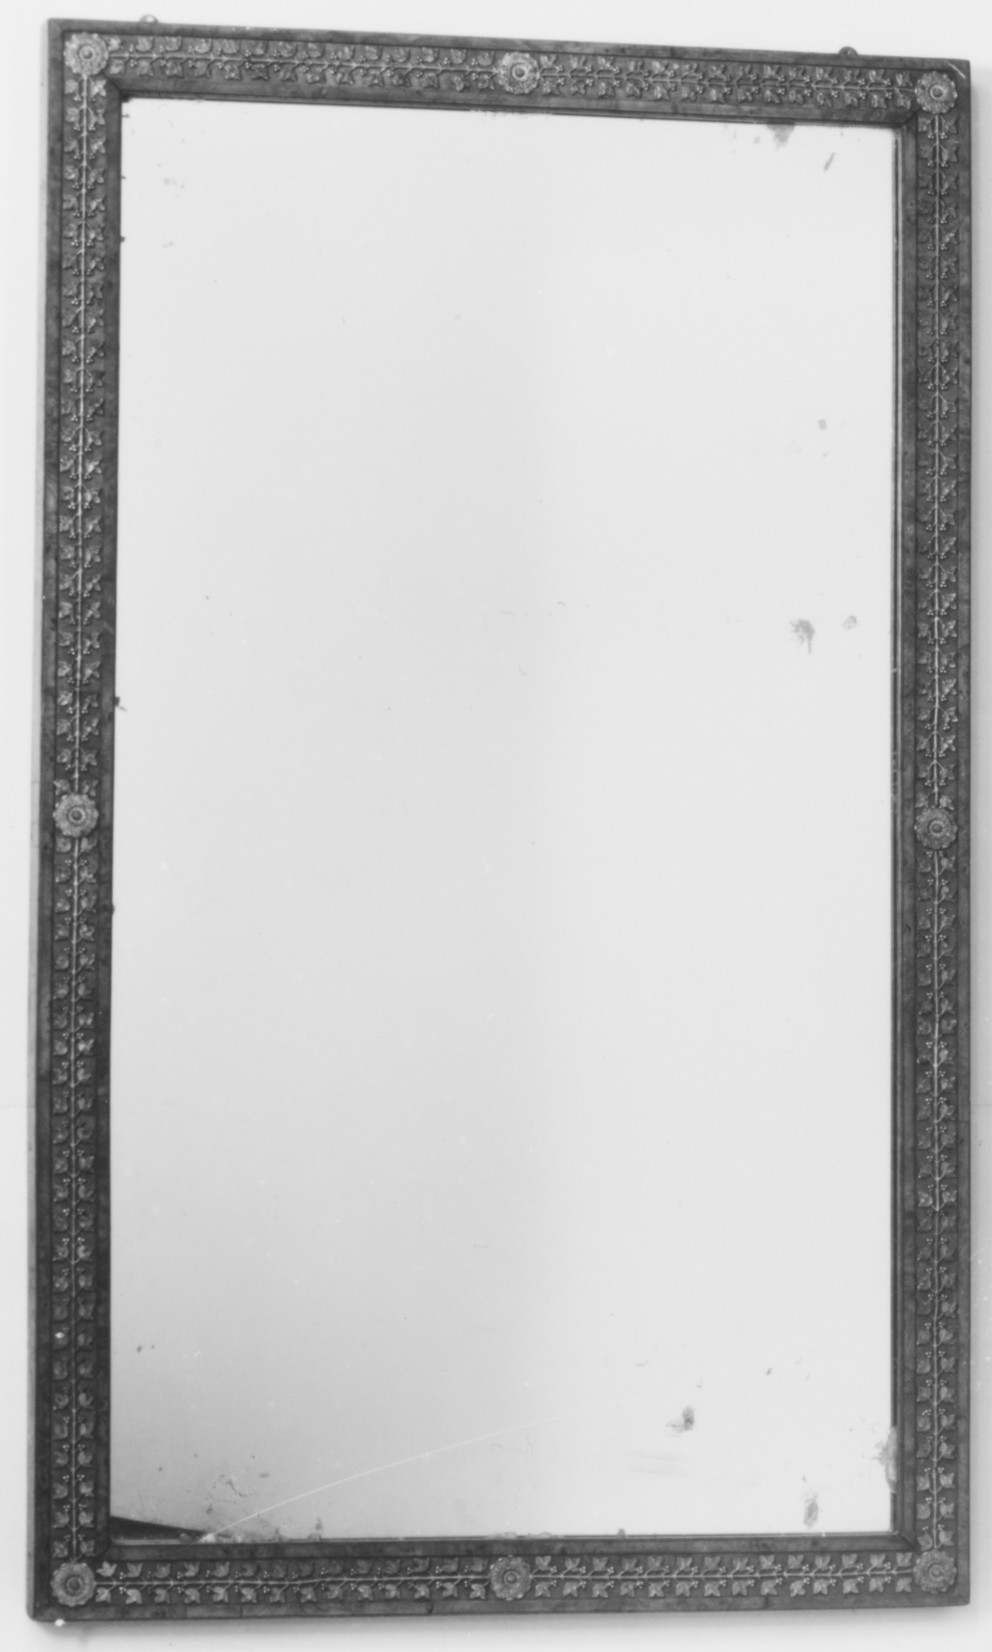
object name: mirror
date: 1801-1833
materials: gilt bronze, wood